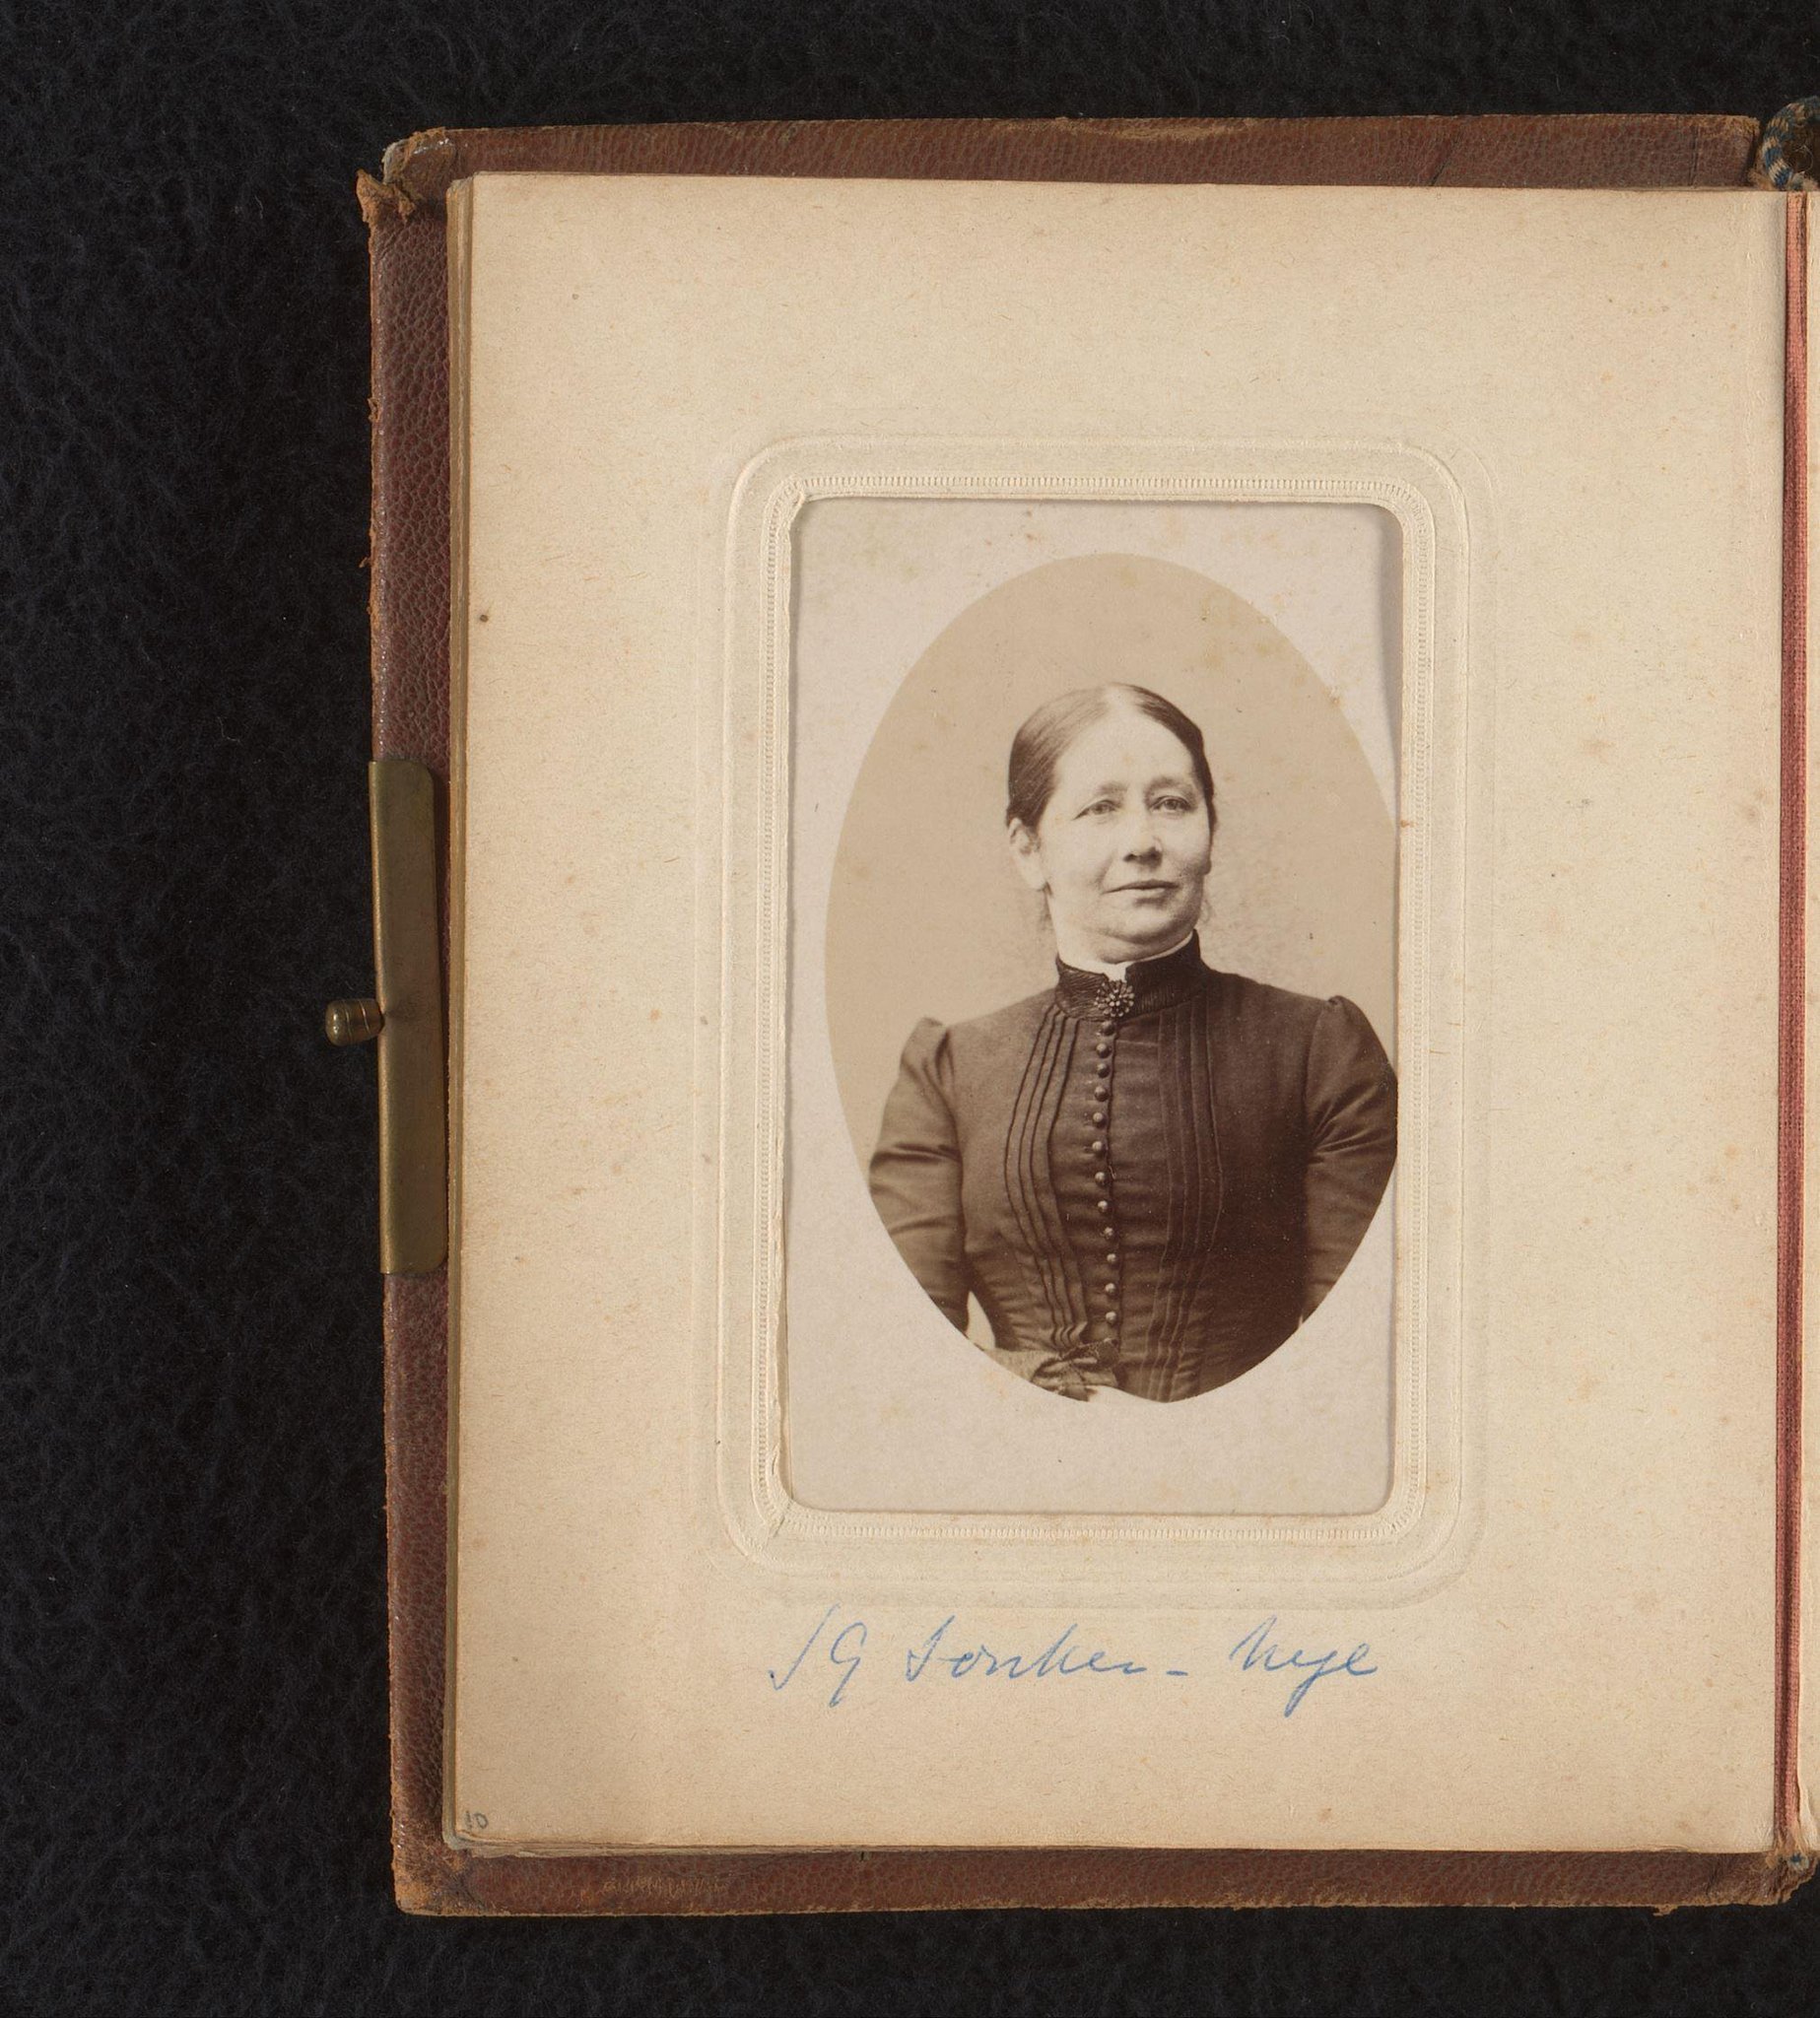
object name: album leaf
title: Portret van Johanna Geertruida Jonker-Nije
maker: johannes leonardus van der heijden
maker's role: fotograaf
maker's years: 1856-1937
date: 1878-1900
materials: cardboard, photographic support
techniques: albumen print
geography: amsterdam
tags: adolescent, young woman, maiden, historical persons - bb - woman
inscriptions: inscription: ‘Photographie Artistique/ Joh. L. van der Heijden/ Amsterdam/ Heiligenweg hoek Singel 435’, name: ‘J.G. Jonker-Nije’